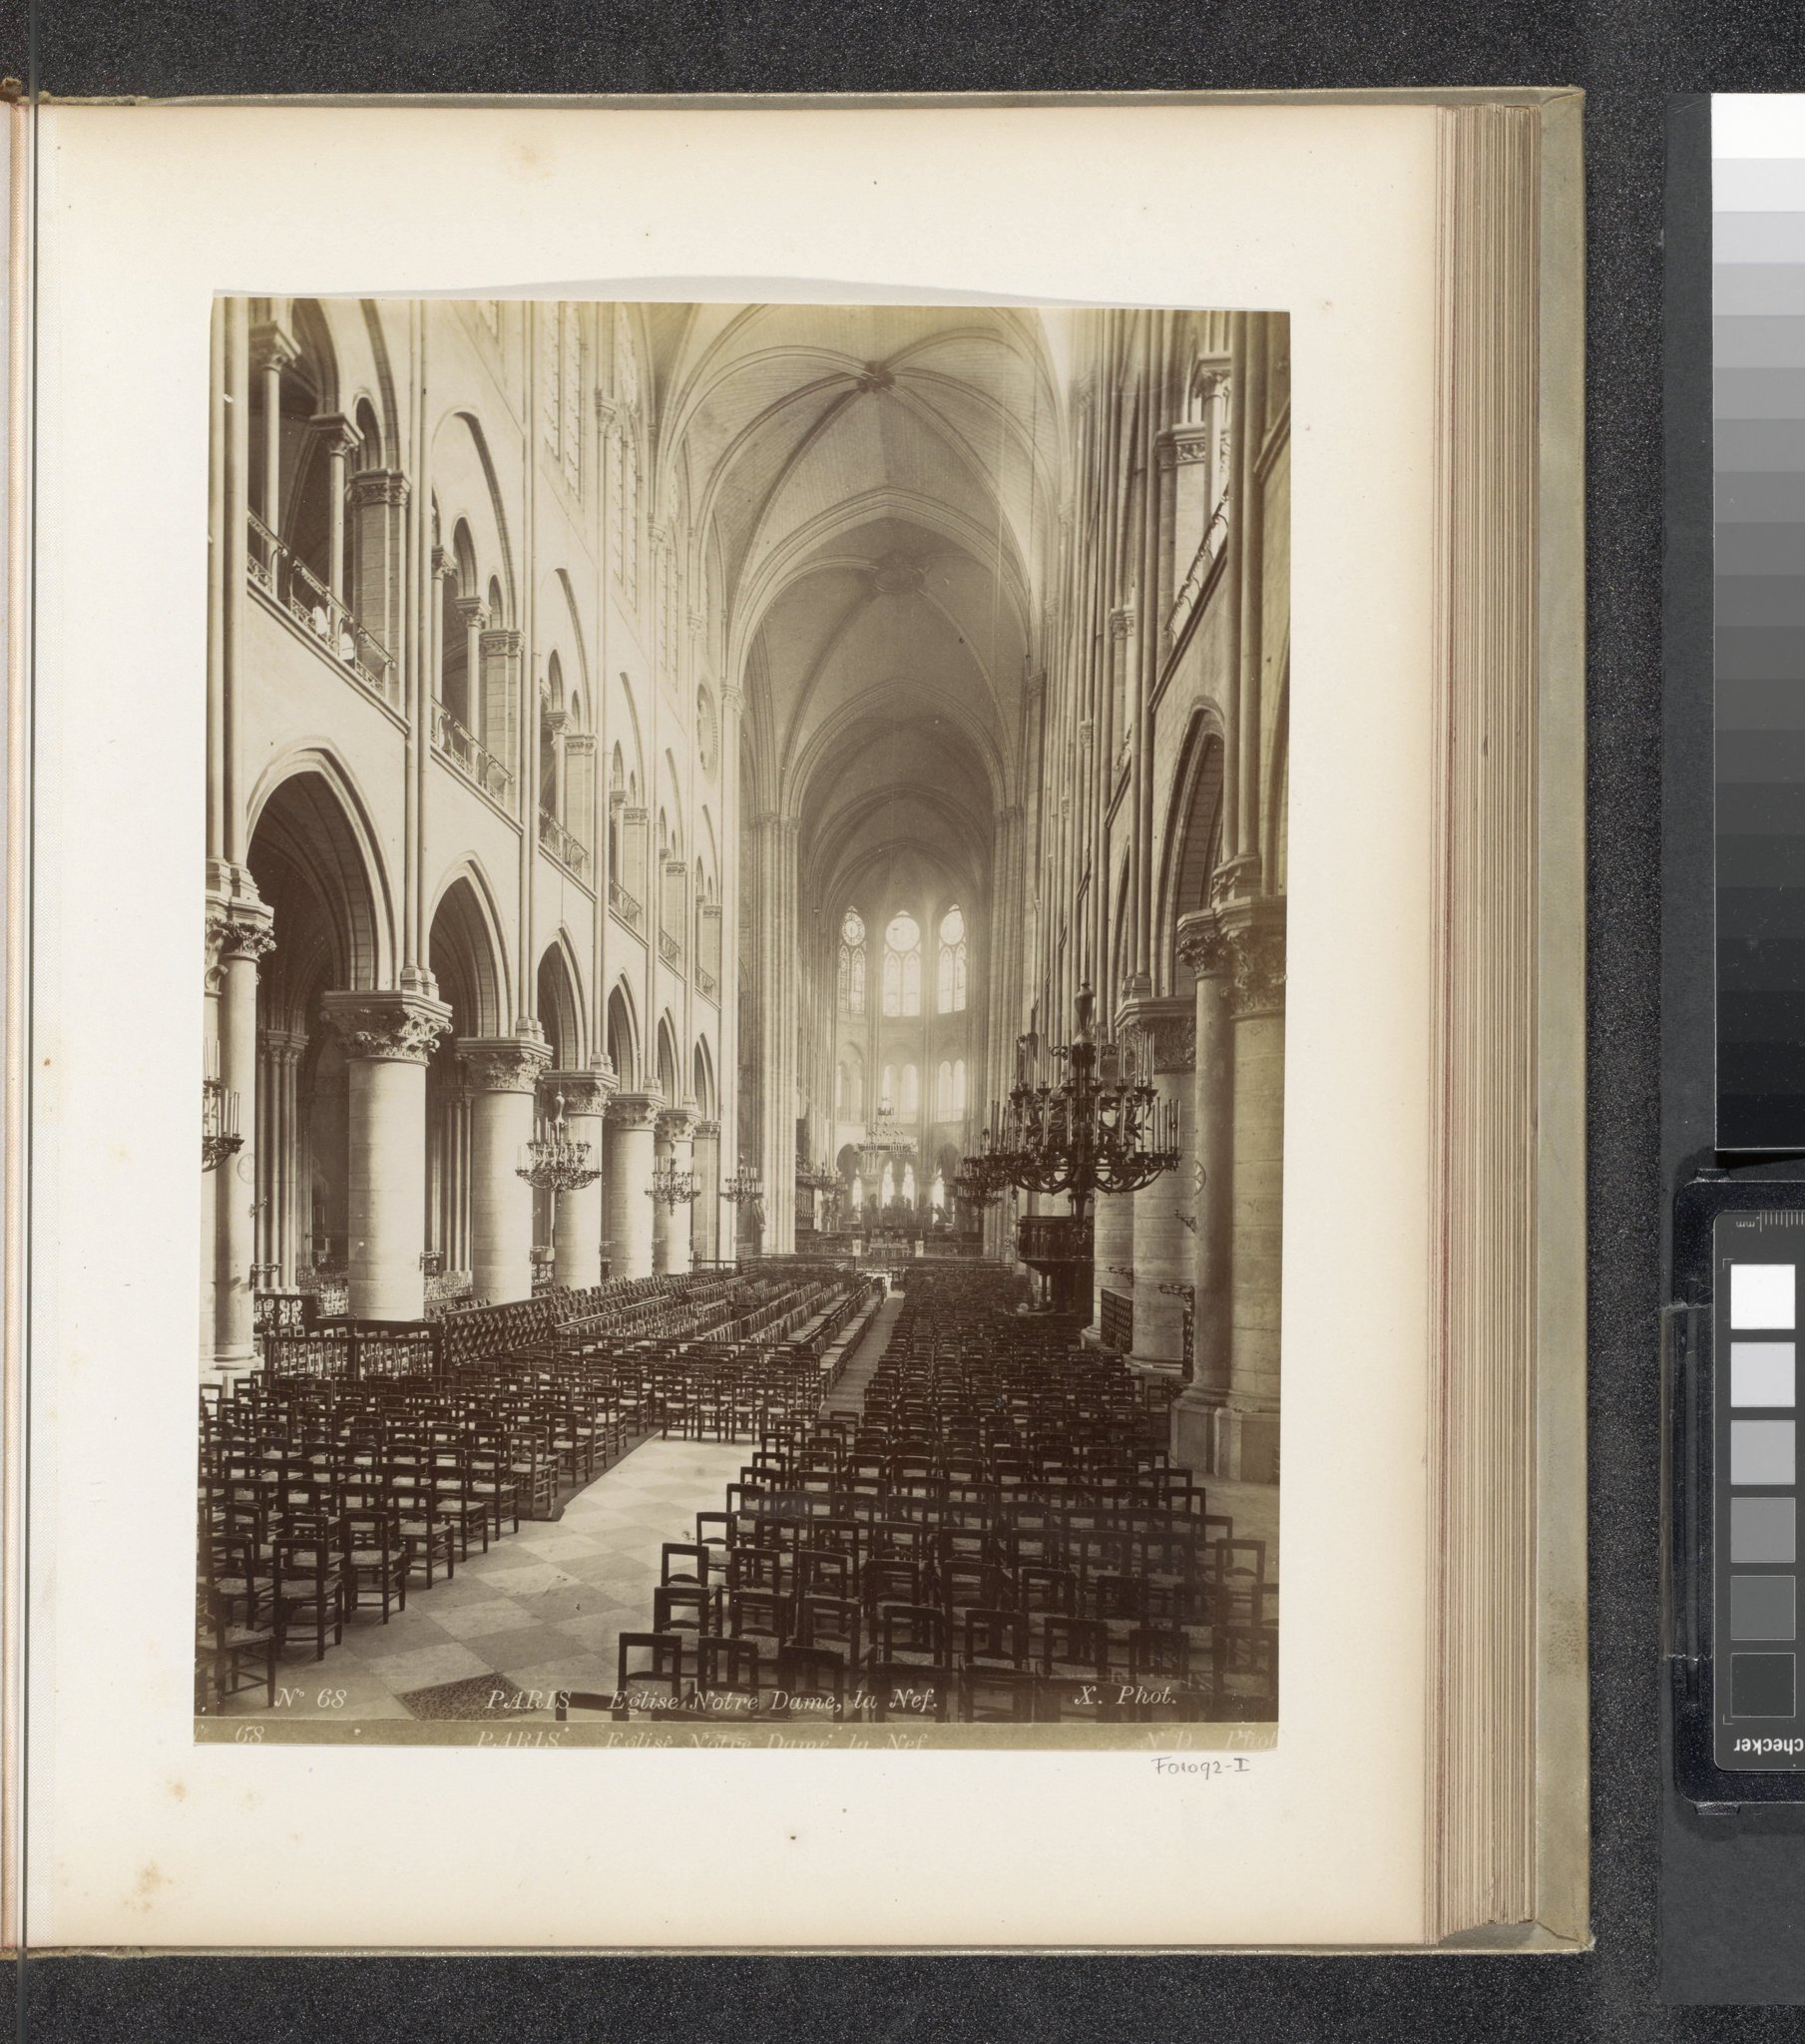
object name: photograph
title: PARIS Eglise Notre-Dame, la Nef.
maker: étienne neurdein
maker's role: publisher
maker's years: 1832-1918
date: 1880-1900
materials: cardboard, paper, photographic support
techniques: albumen print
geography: paris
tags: parts of church interior: nave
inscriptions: negative number: ‘68’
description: Onderdeel van Reisalbum met foto's van bezienswaardigheden in België en Frankrijk.